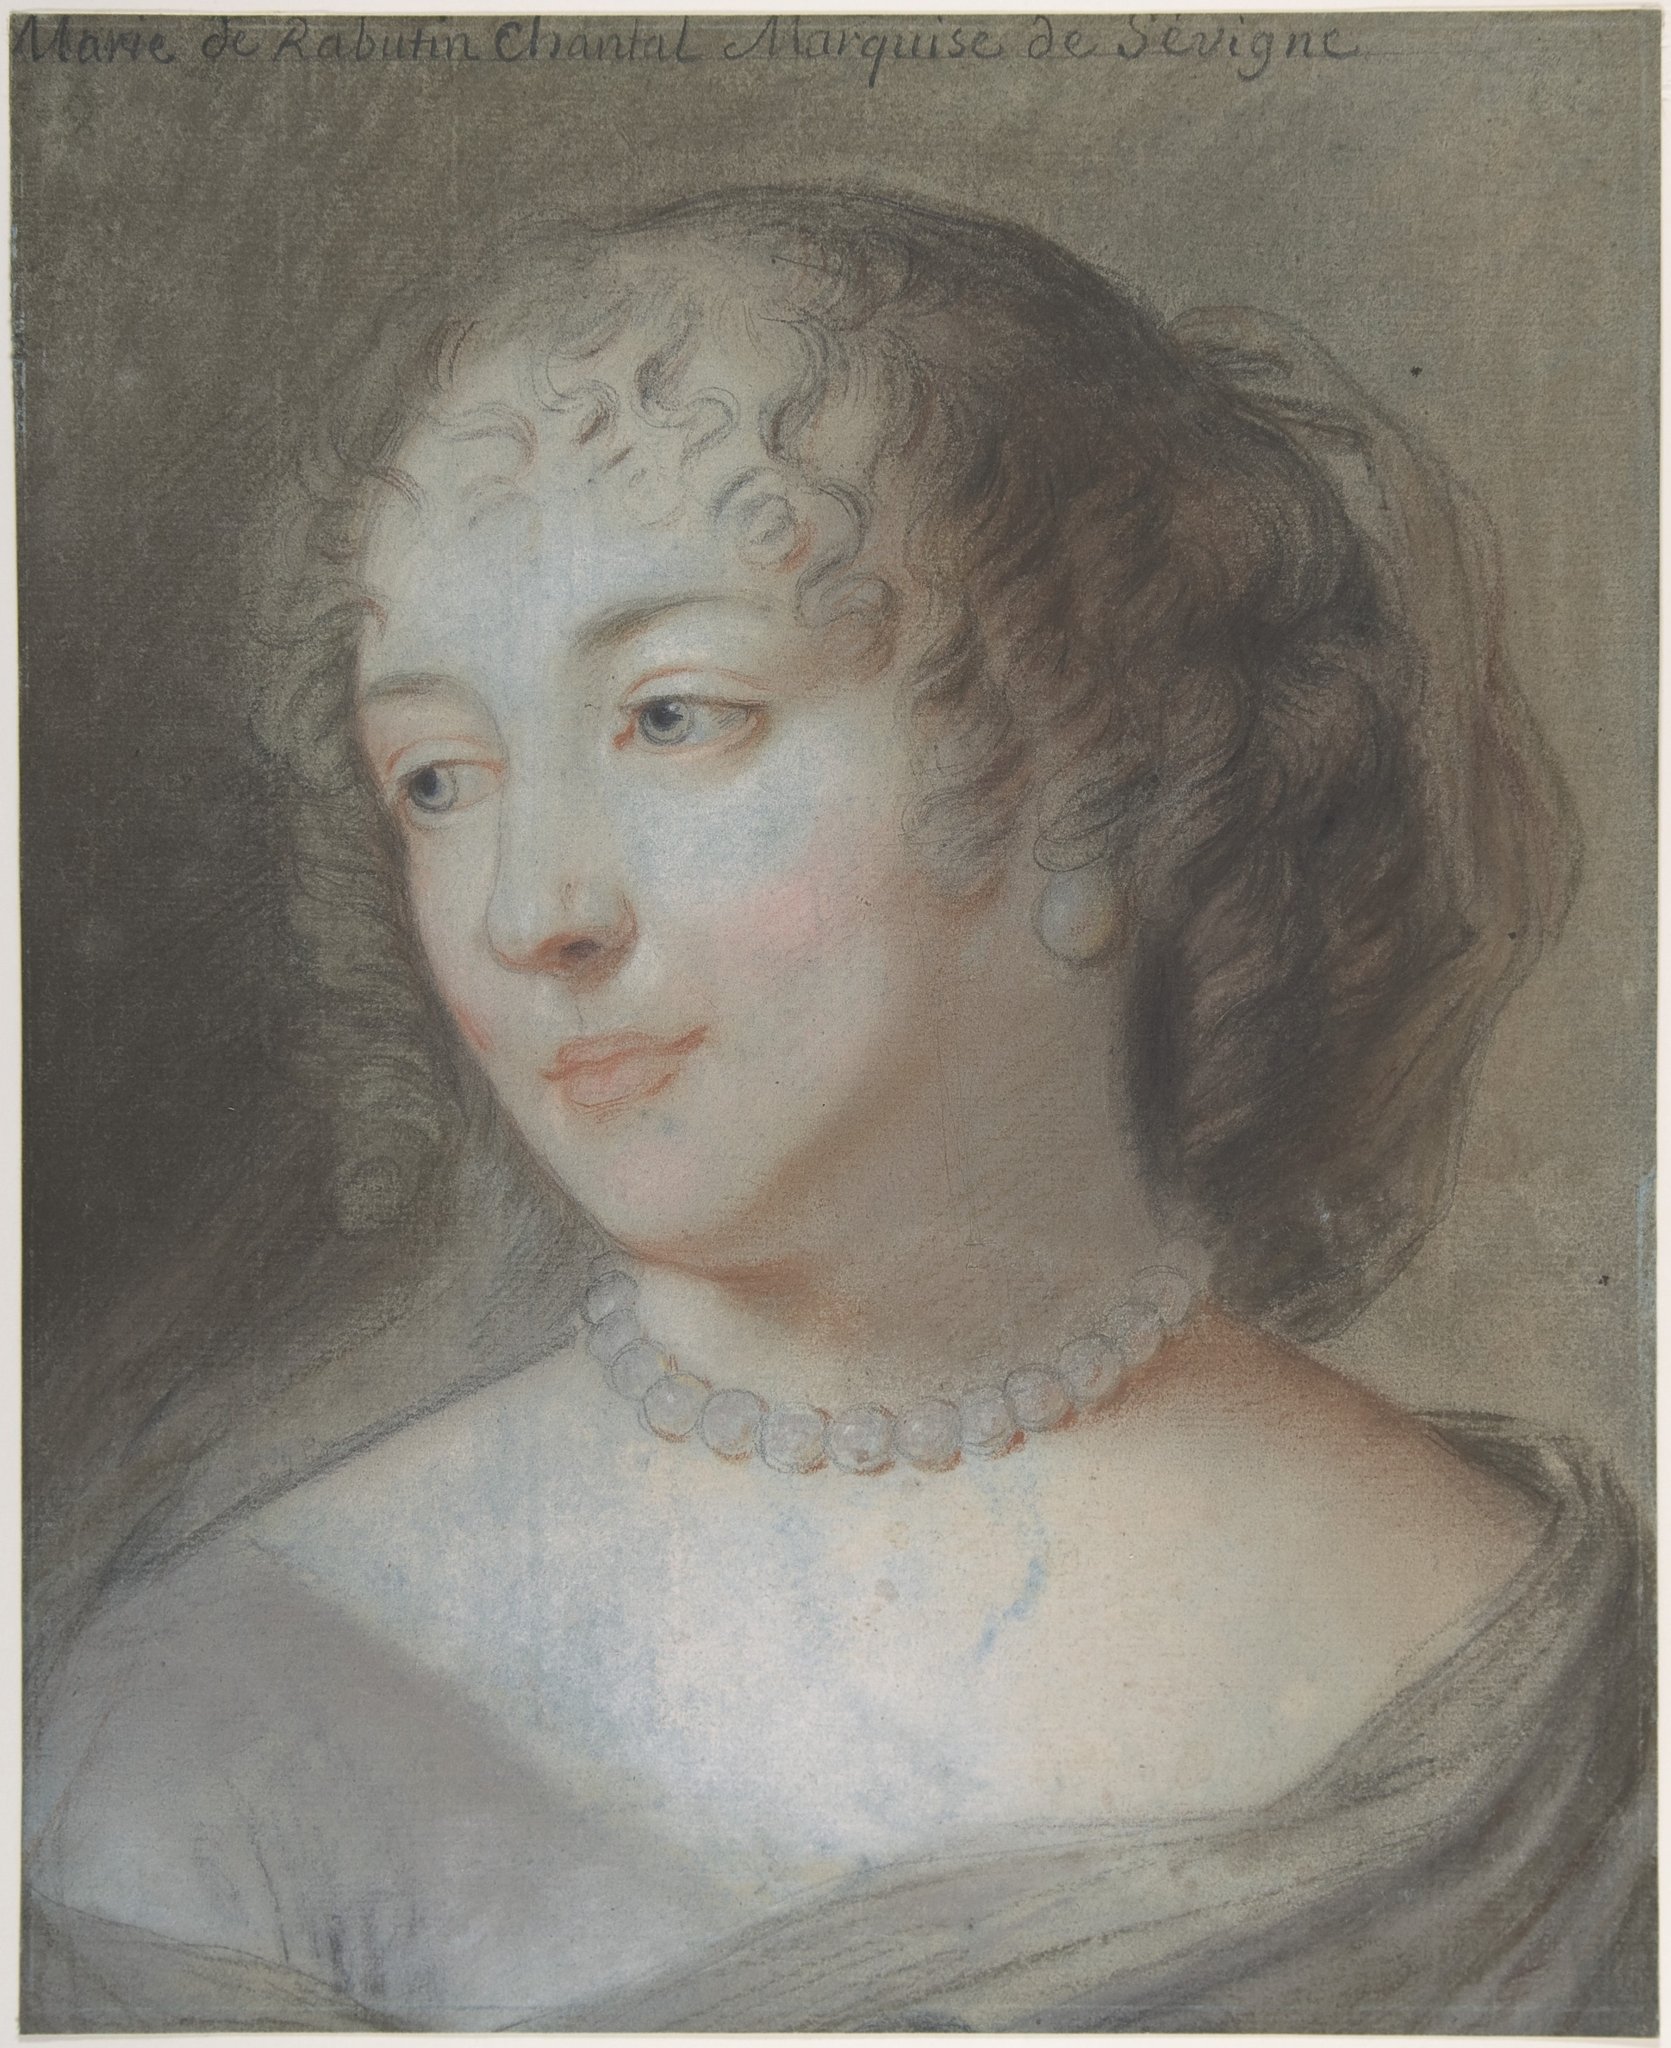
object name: drawing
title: Portrait of Marie de Rabutin-Chantal, Marquise de Sévigné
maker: claude lefèbvre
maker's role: painter, print maker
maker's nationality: french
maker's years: 1632-1675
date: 1601-1700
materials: chalk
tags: portraits,women